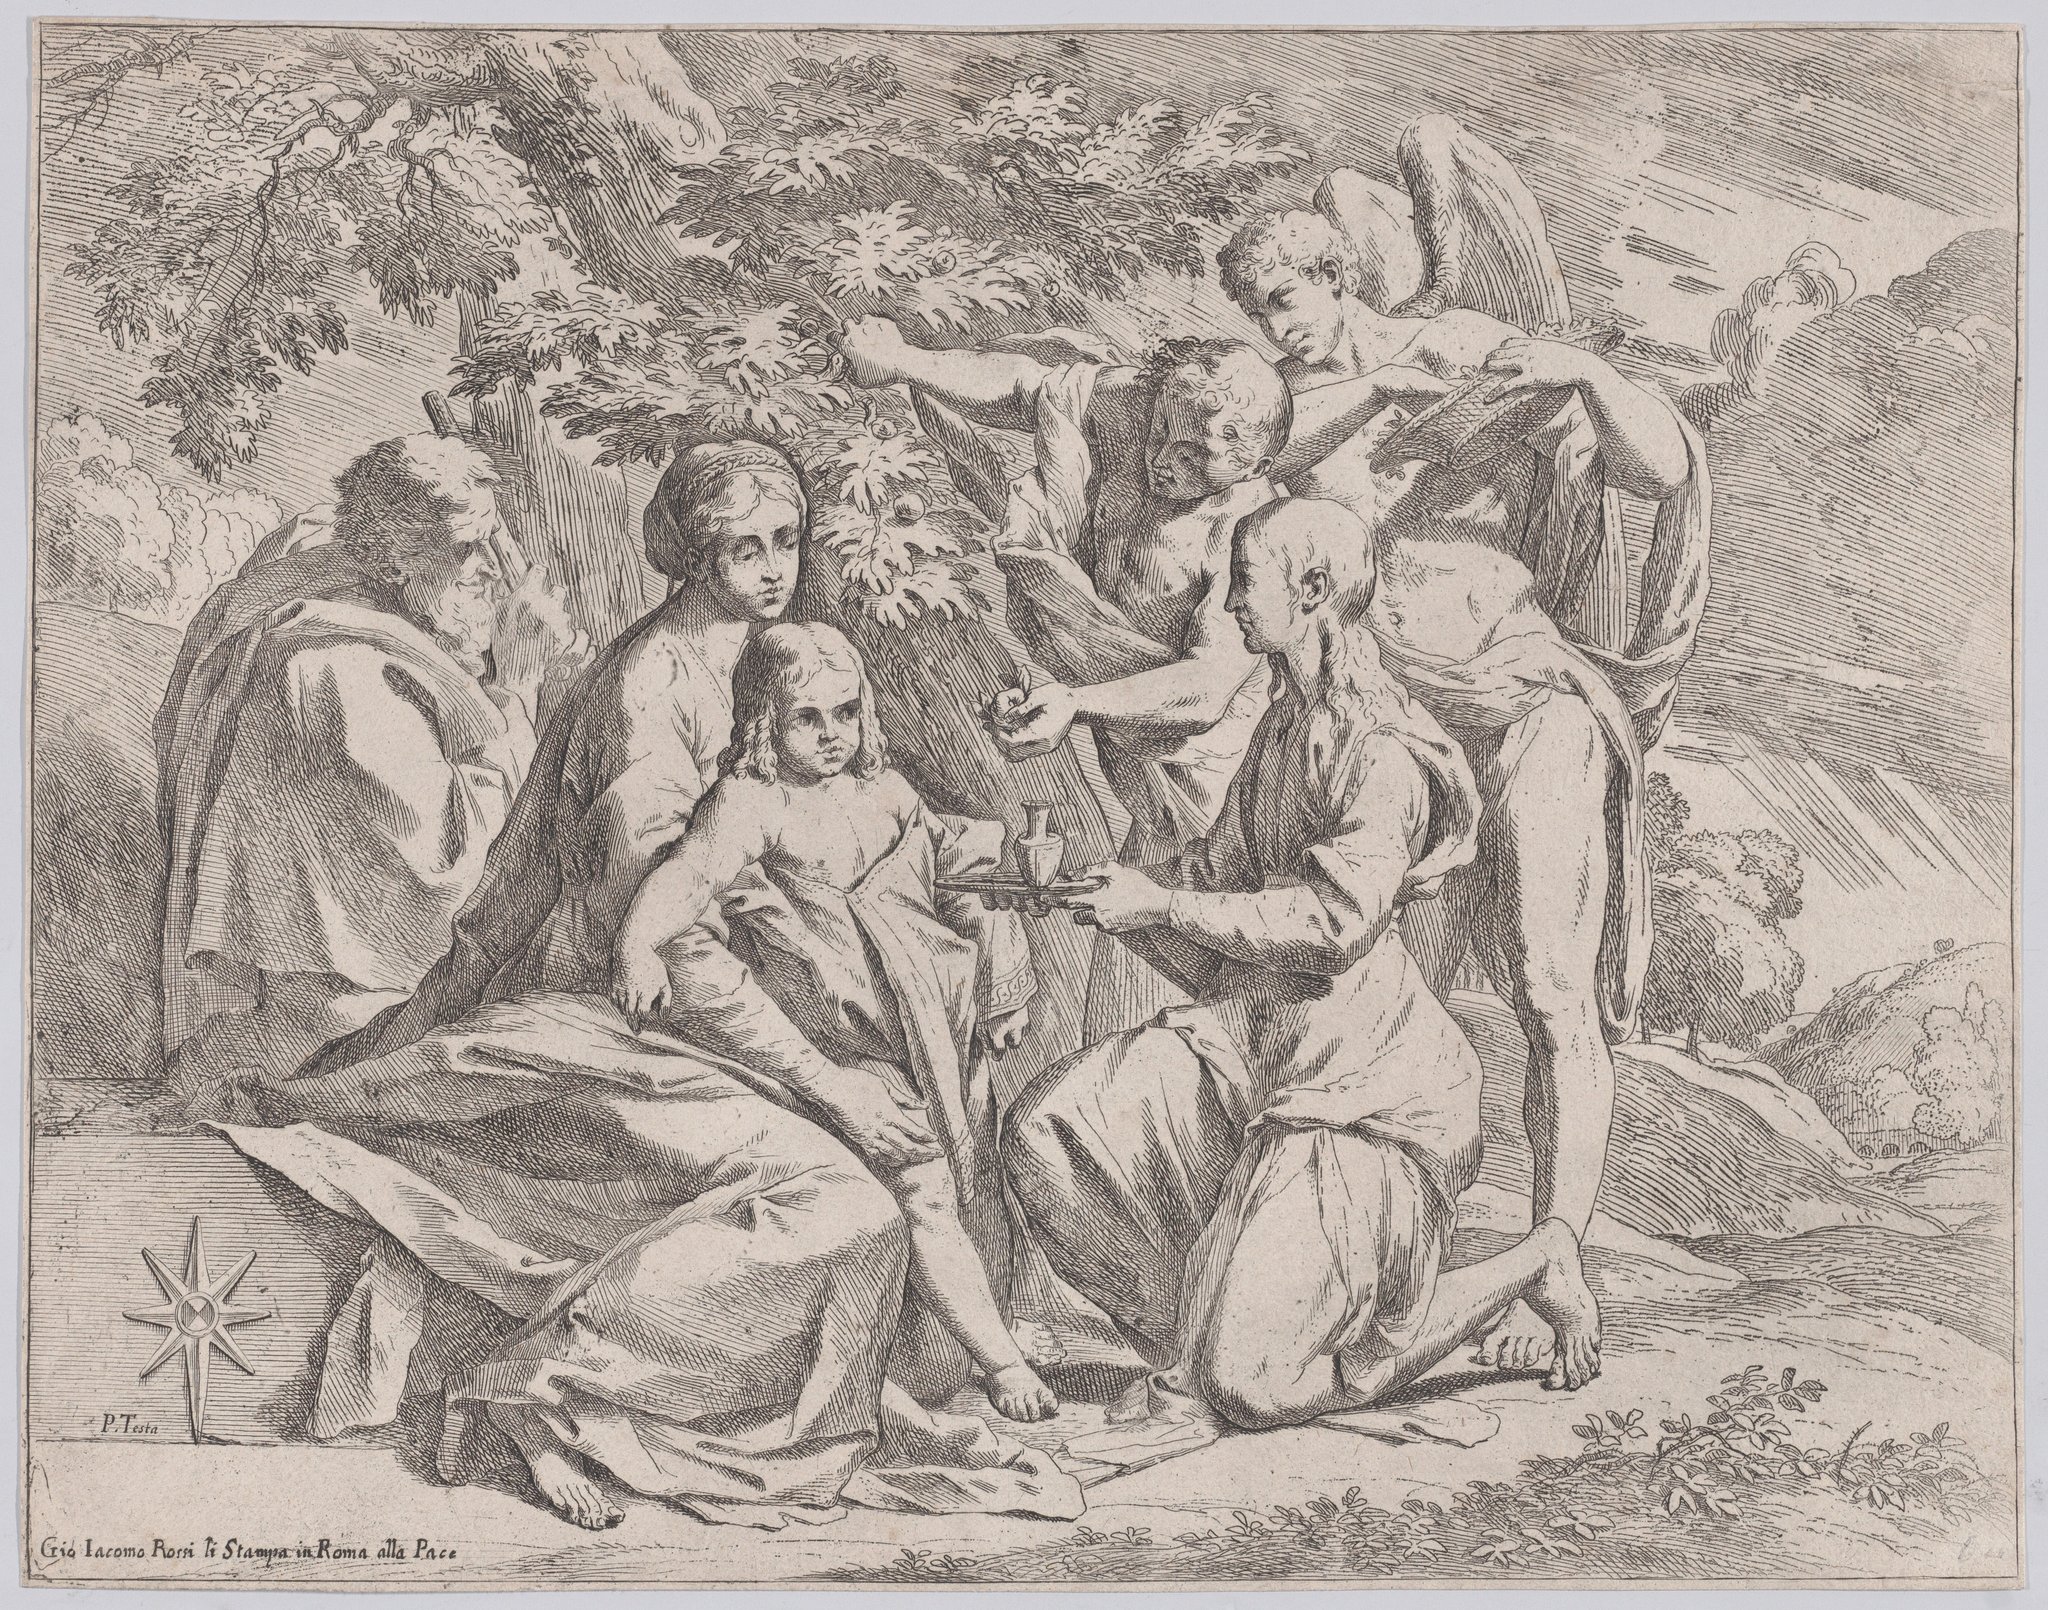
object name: print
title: The Holy Family fed by Angels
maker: pietro testa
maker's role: artist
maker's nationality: italian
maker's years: 1612-1650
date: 1642-1644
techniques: etching